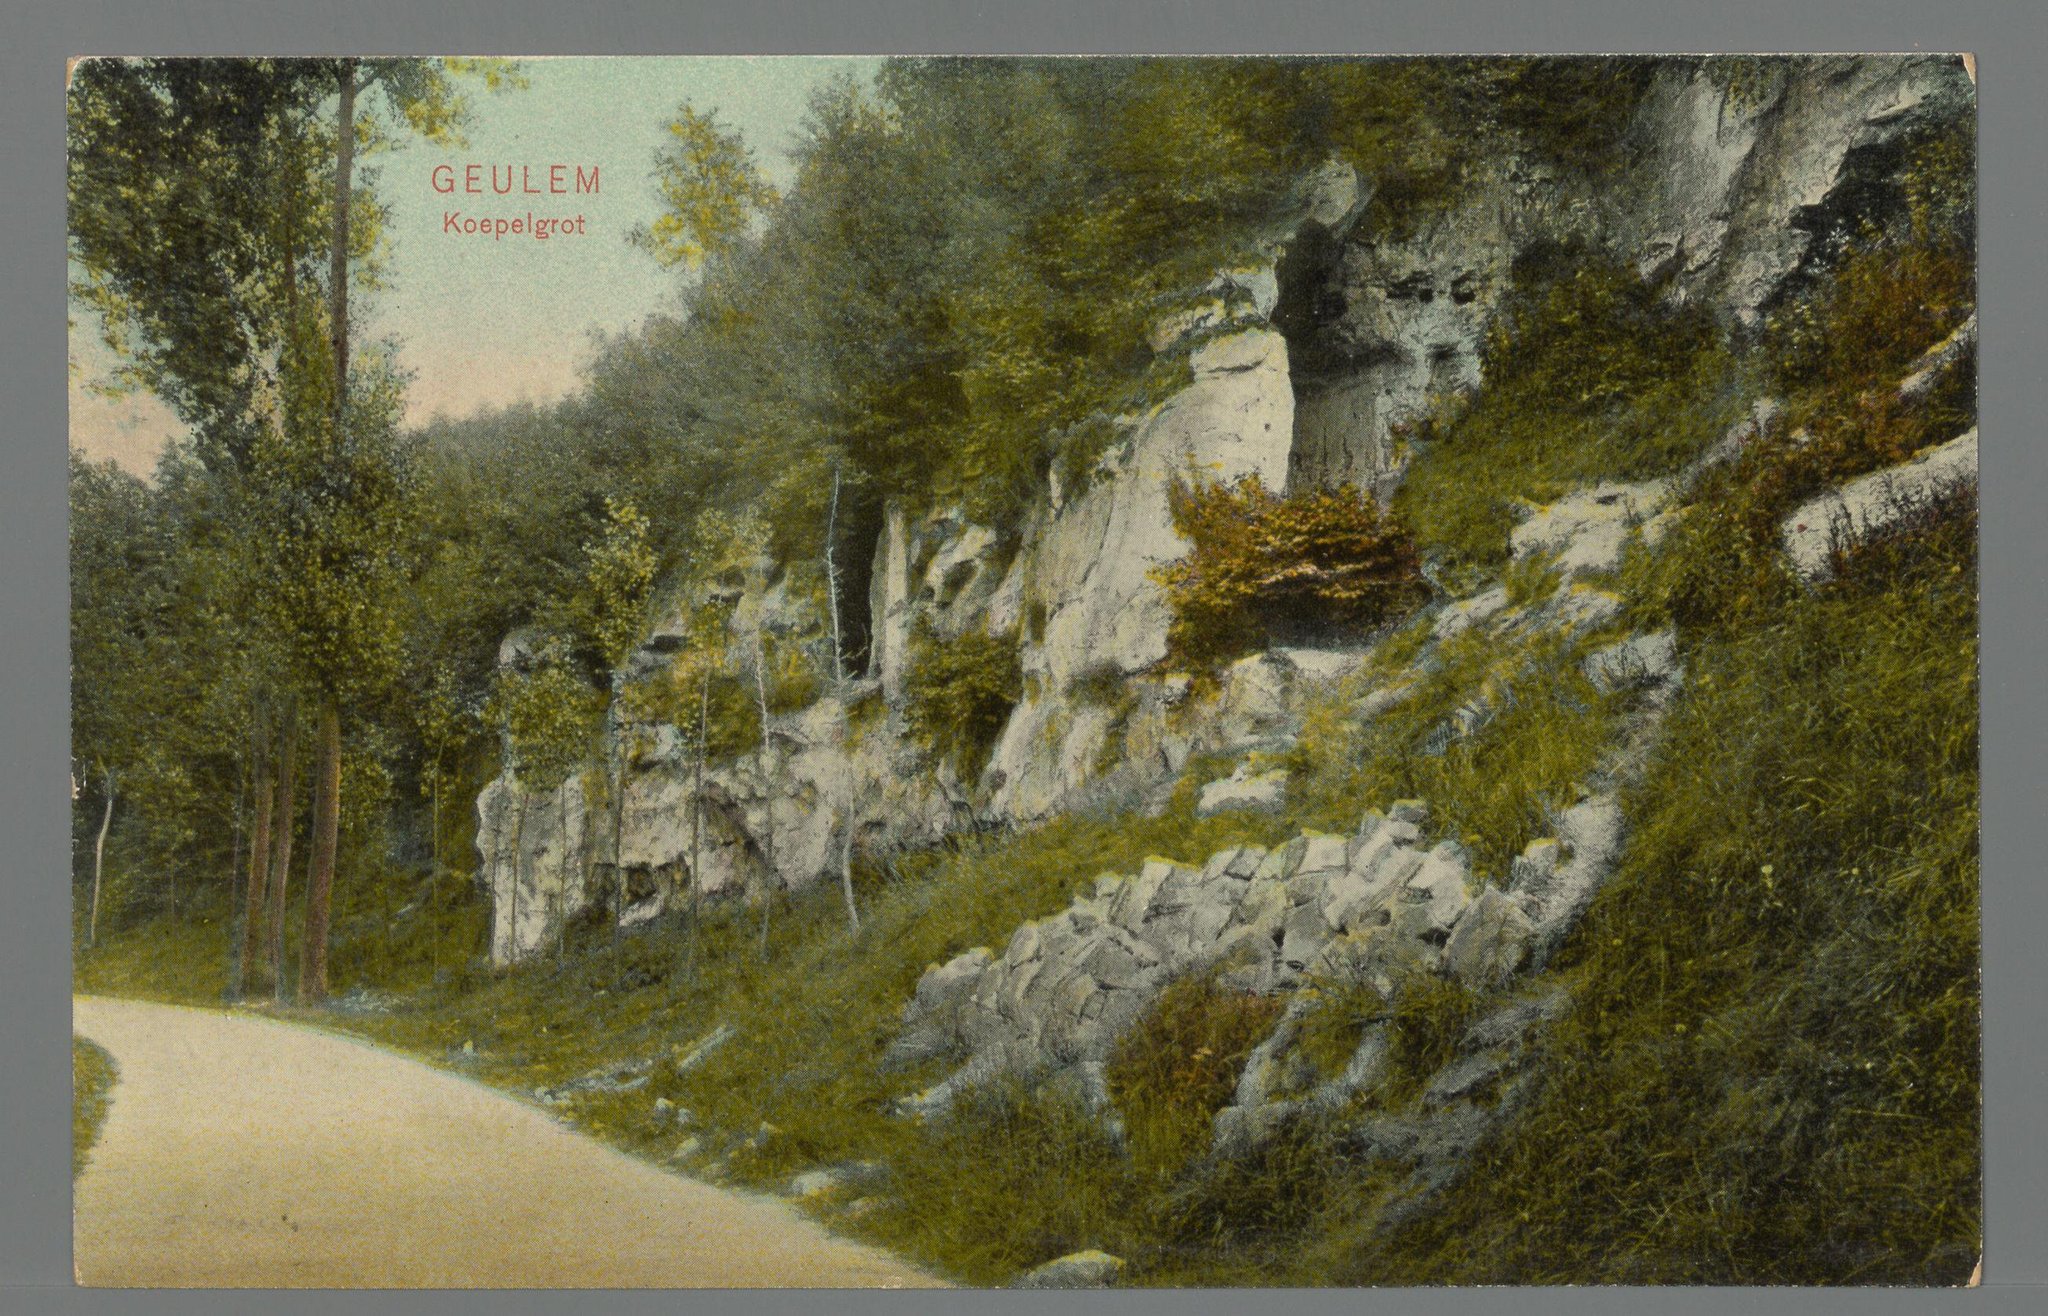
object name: photomechanical print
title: Geulem. Koepelgrot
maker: Anonymous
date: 1908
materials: cardboard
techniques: lithograph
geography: leipzig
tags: cave, grotto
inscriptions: date